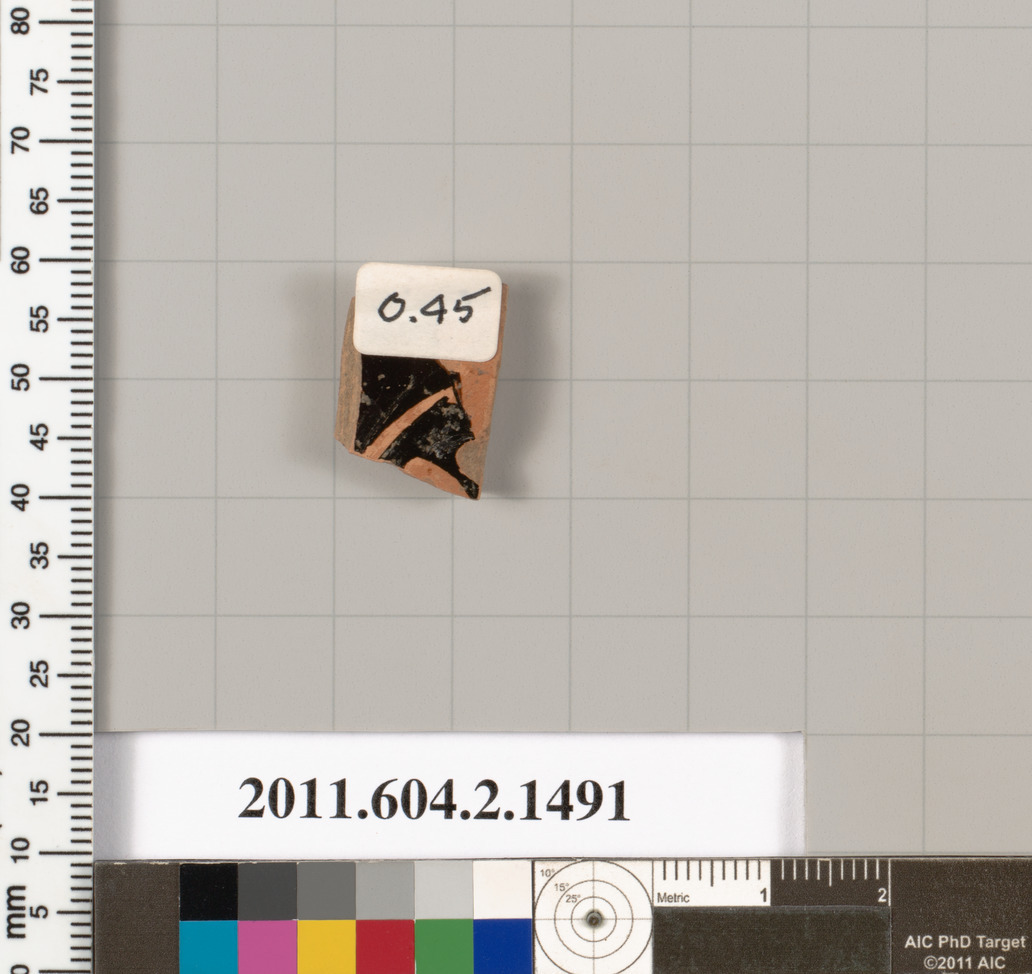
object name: skyphos fragment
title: Terracotta fragment of a skyphos (deep drinking cup)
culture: greek, attic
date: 500-451 BCE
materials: terracotta